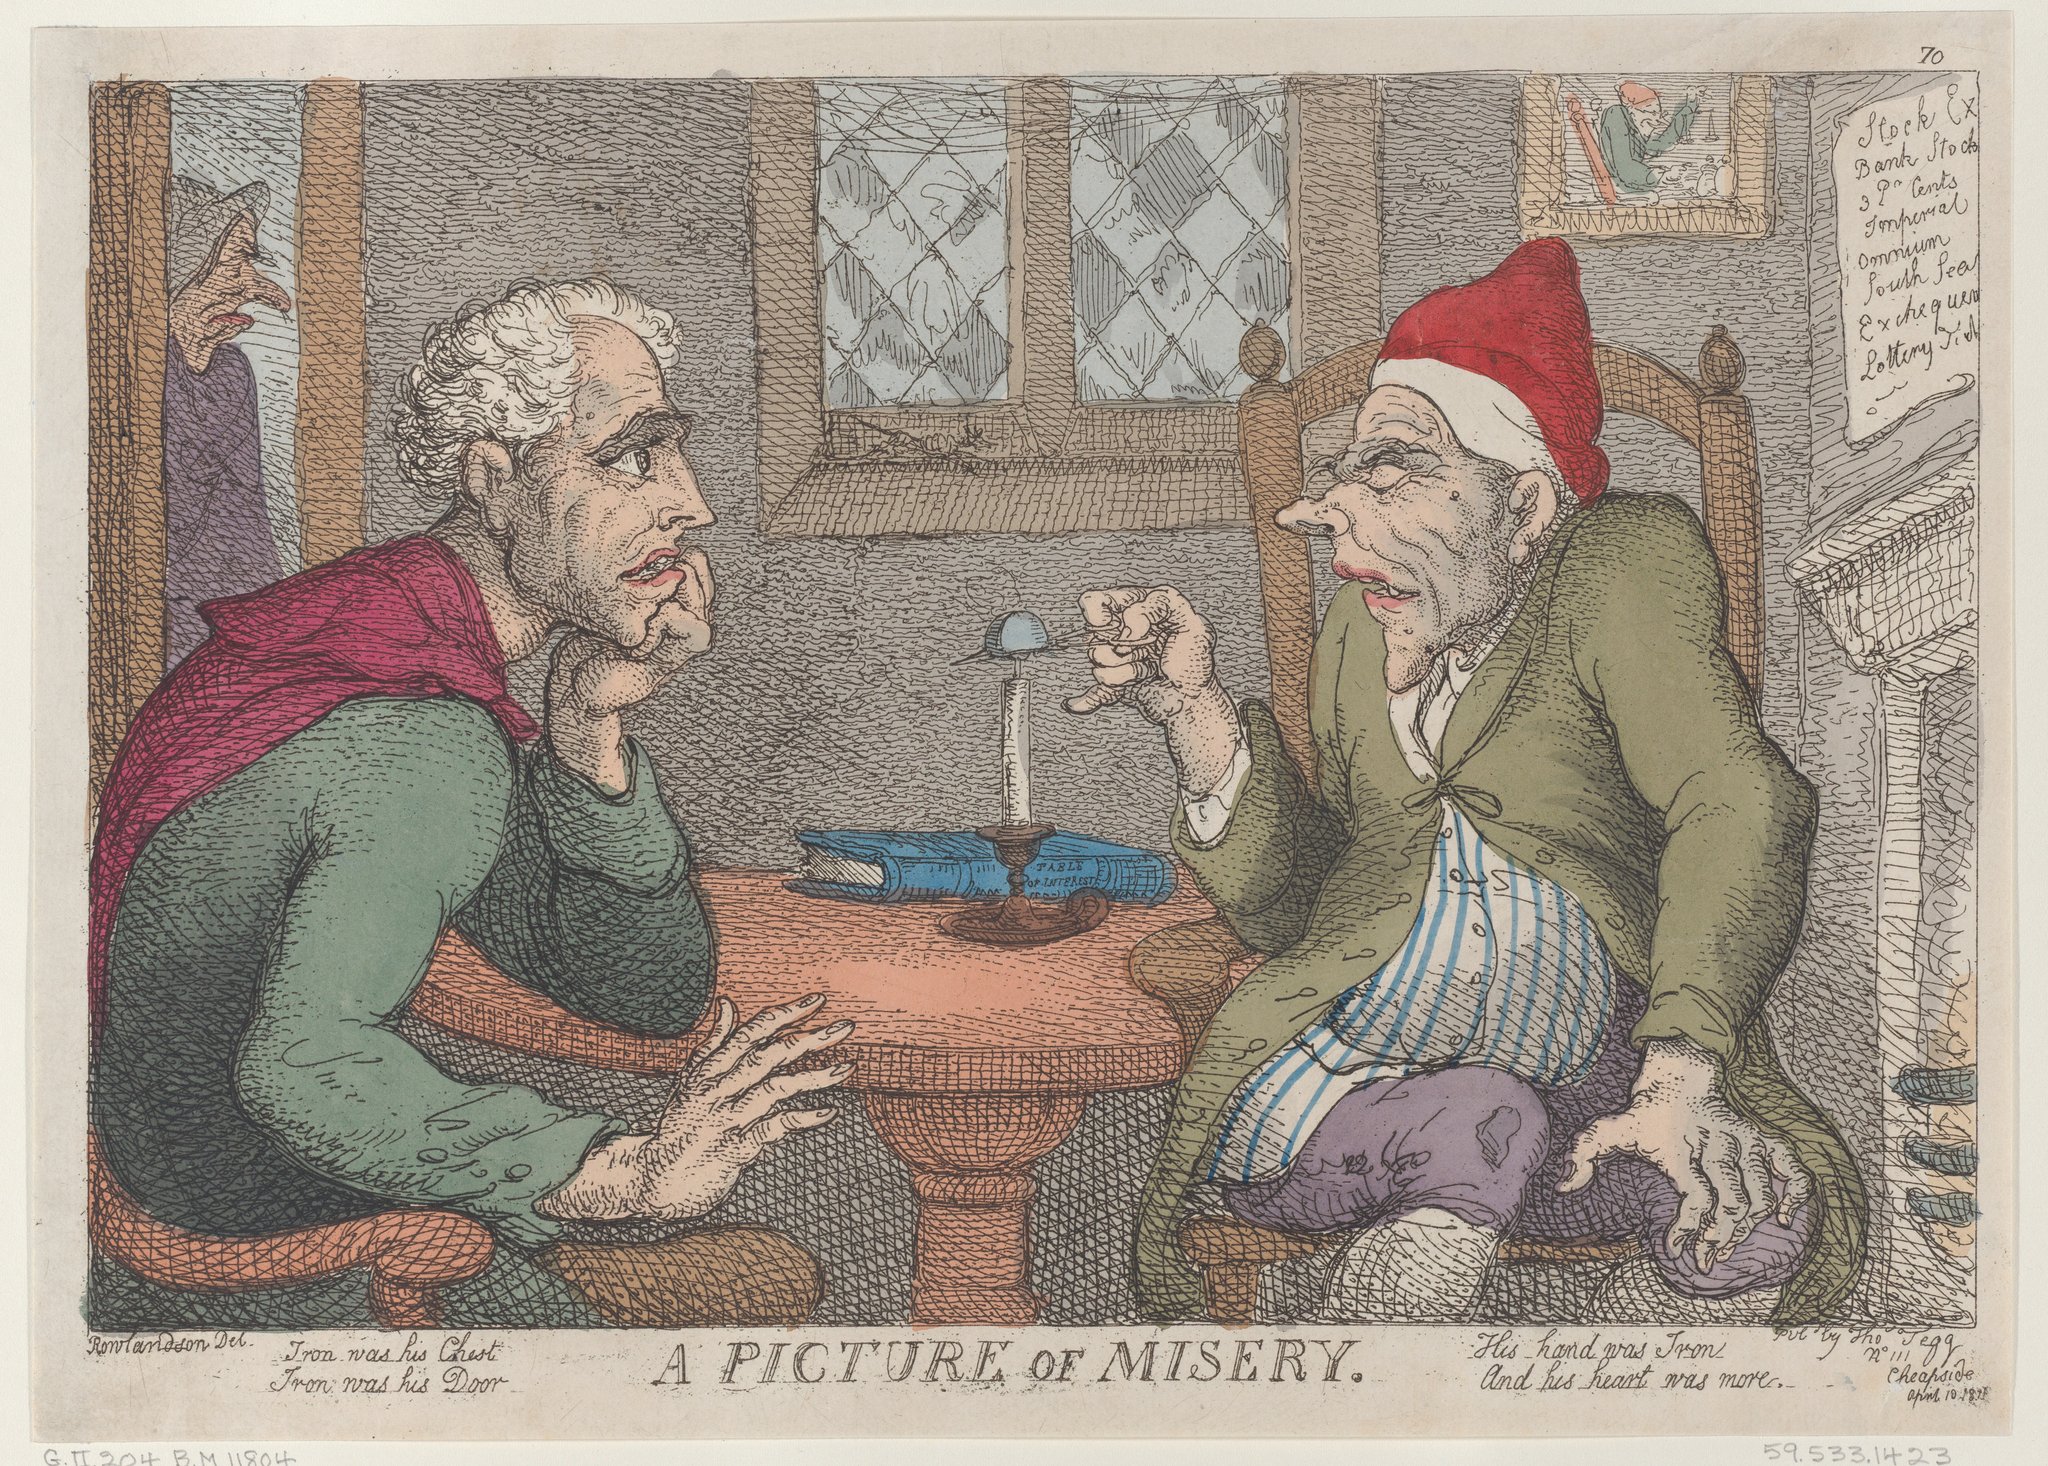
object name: print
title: A Picture of Misery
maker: thomas rowlandson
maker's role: artist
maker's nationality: british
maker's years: 1757-1827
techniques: etching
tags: satire,men